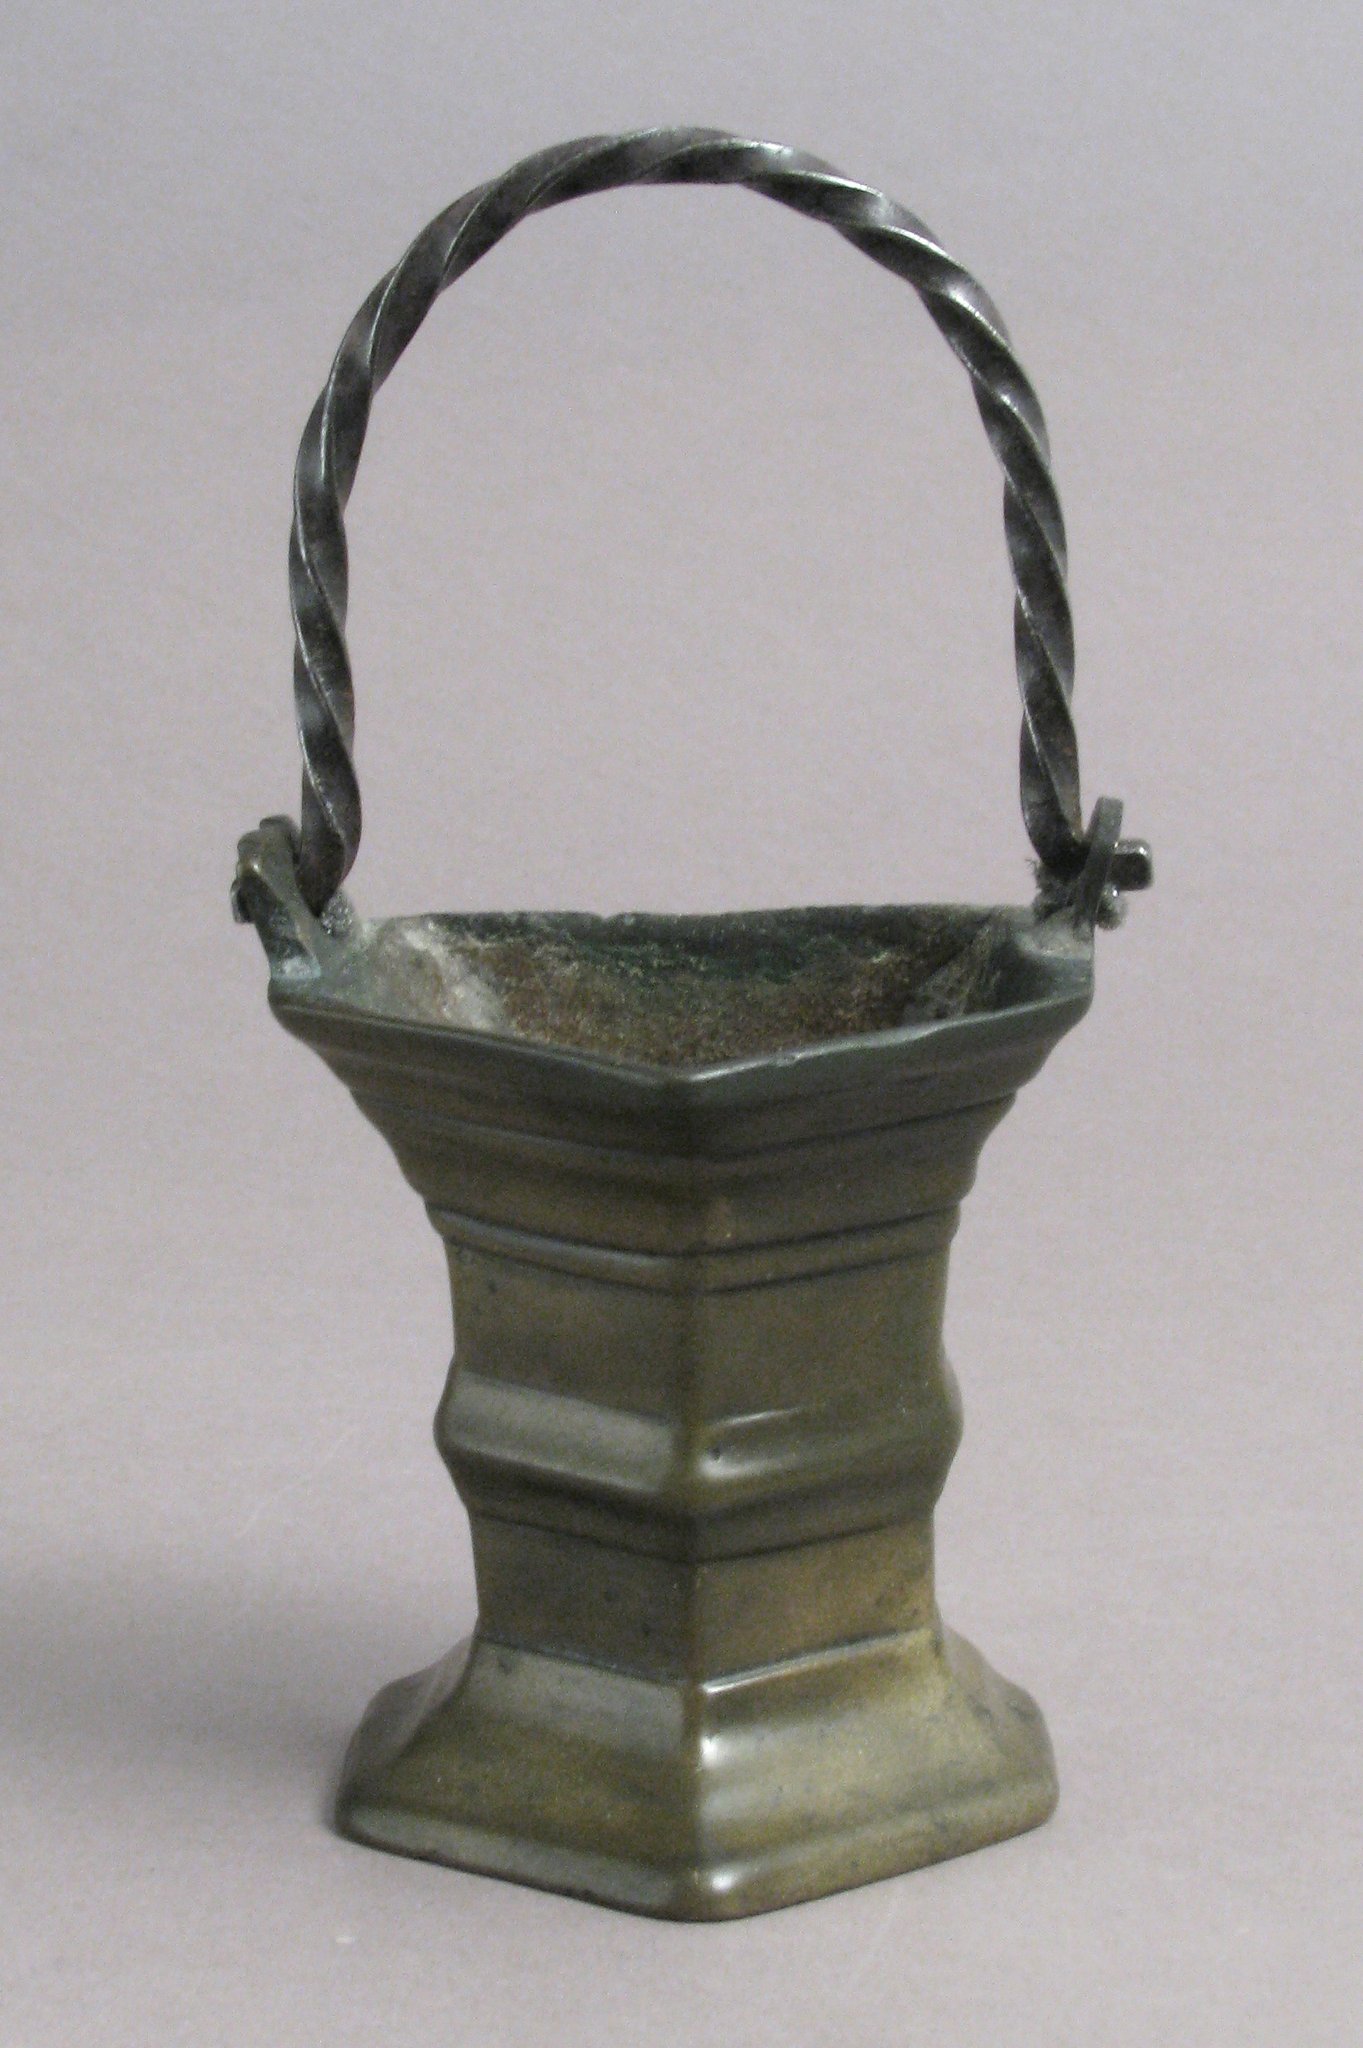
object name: holy water basin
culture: dutch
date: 1401-1600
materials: brass, iron